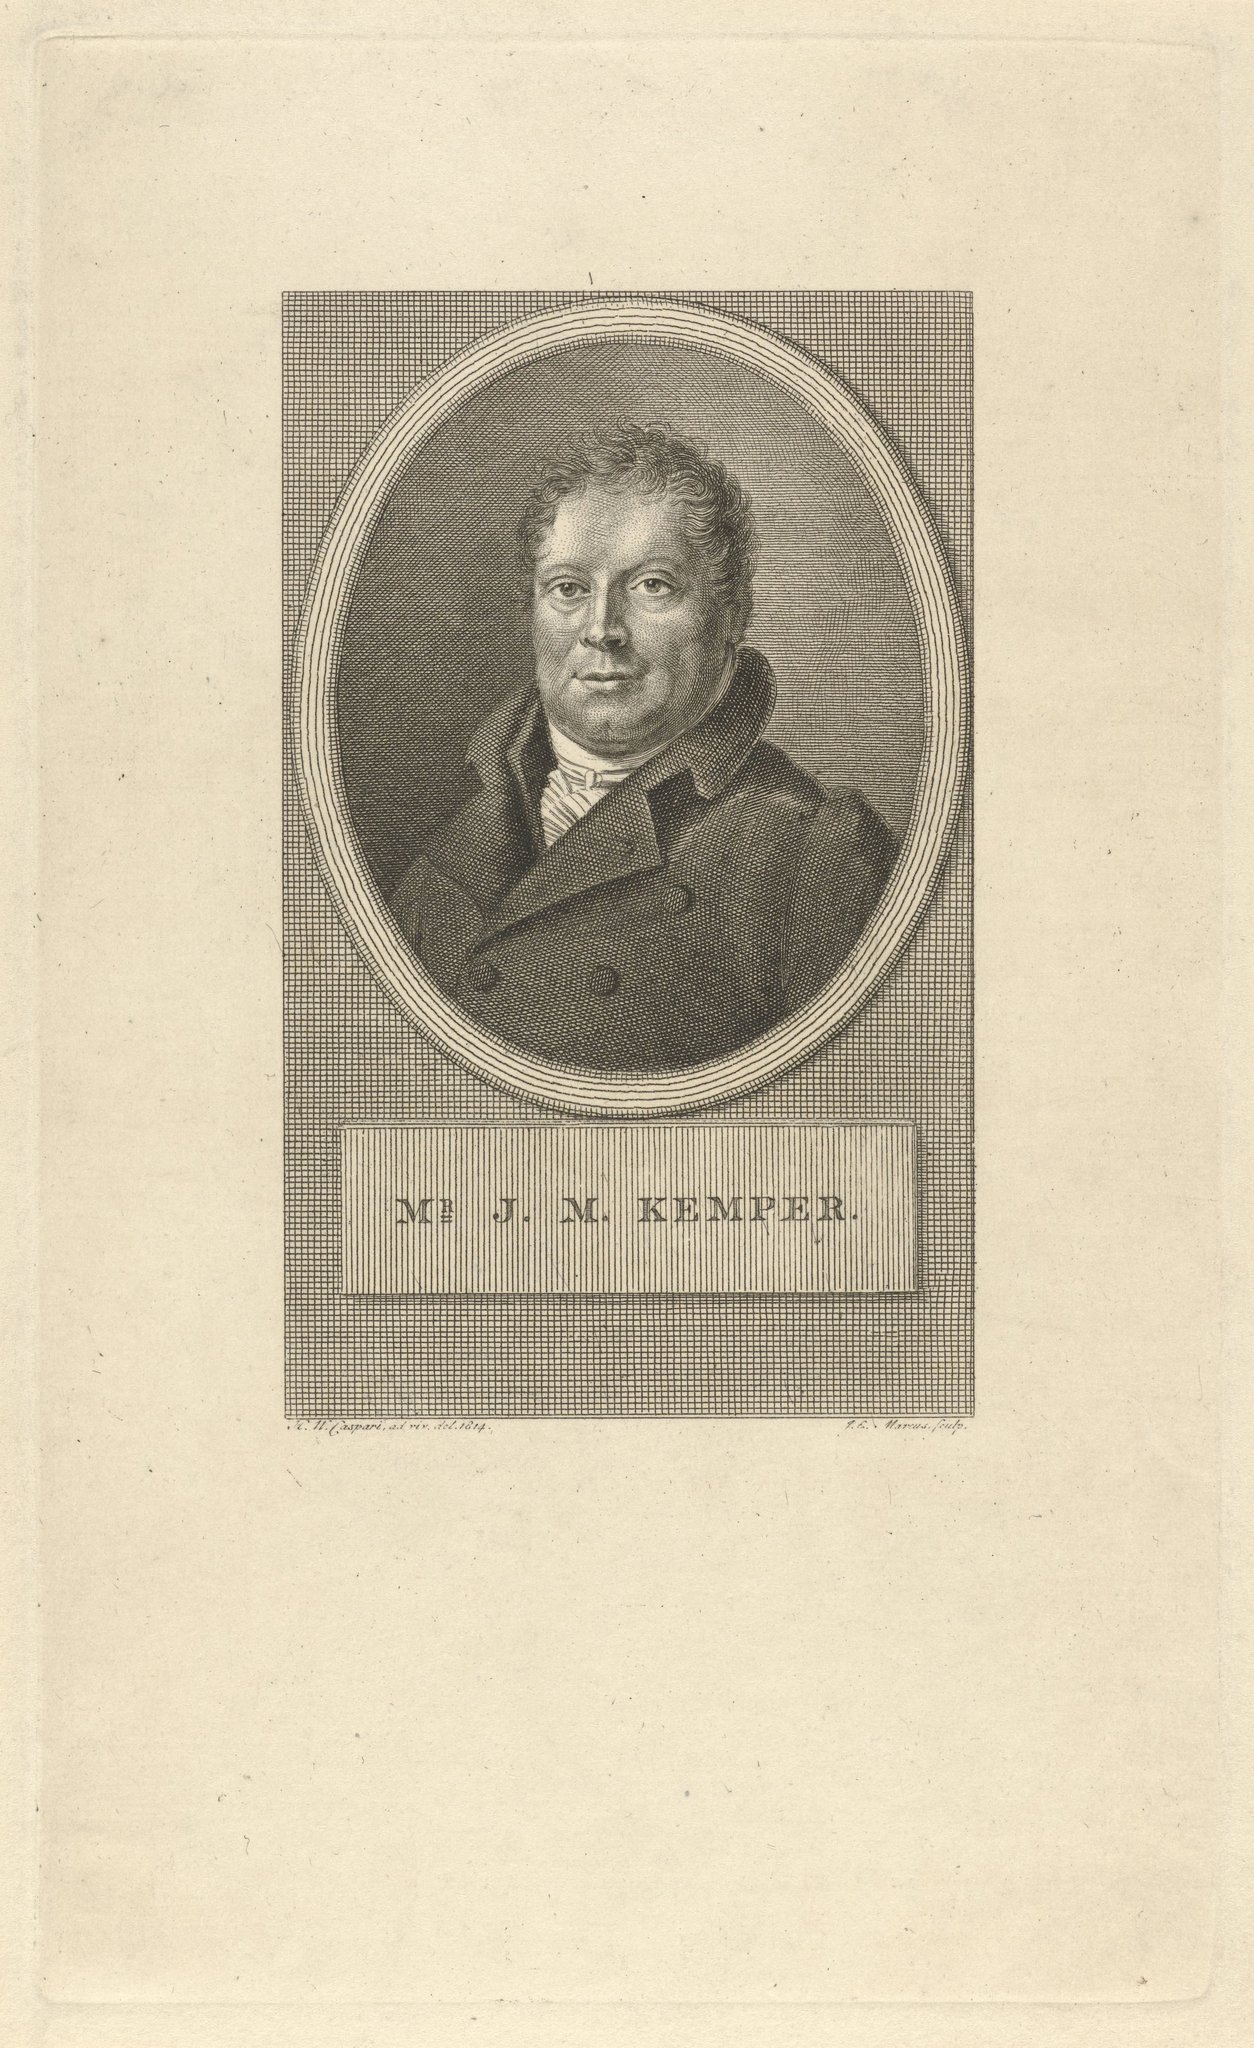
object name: print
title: Portret van Joan Melchior Kemper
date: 1814-1817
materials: paper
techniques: etching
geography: amsterdam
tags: amsterdam, leiden, jonkheer joan melchior kemper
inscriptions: collector's mark: Lugt 2228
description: Prent ook gebruikt in: Herman Bosscha, Geschiedenis der Nederlandsche staatsomwenteling in 1813. 4 dln. Amsterdam: P. den Hengt en zn. en J. van der Hey, 1817.